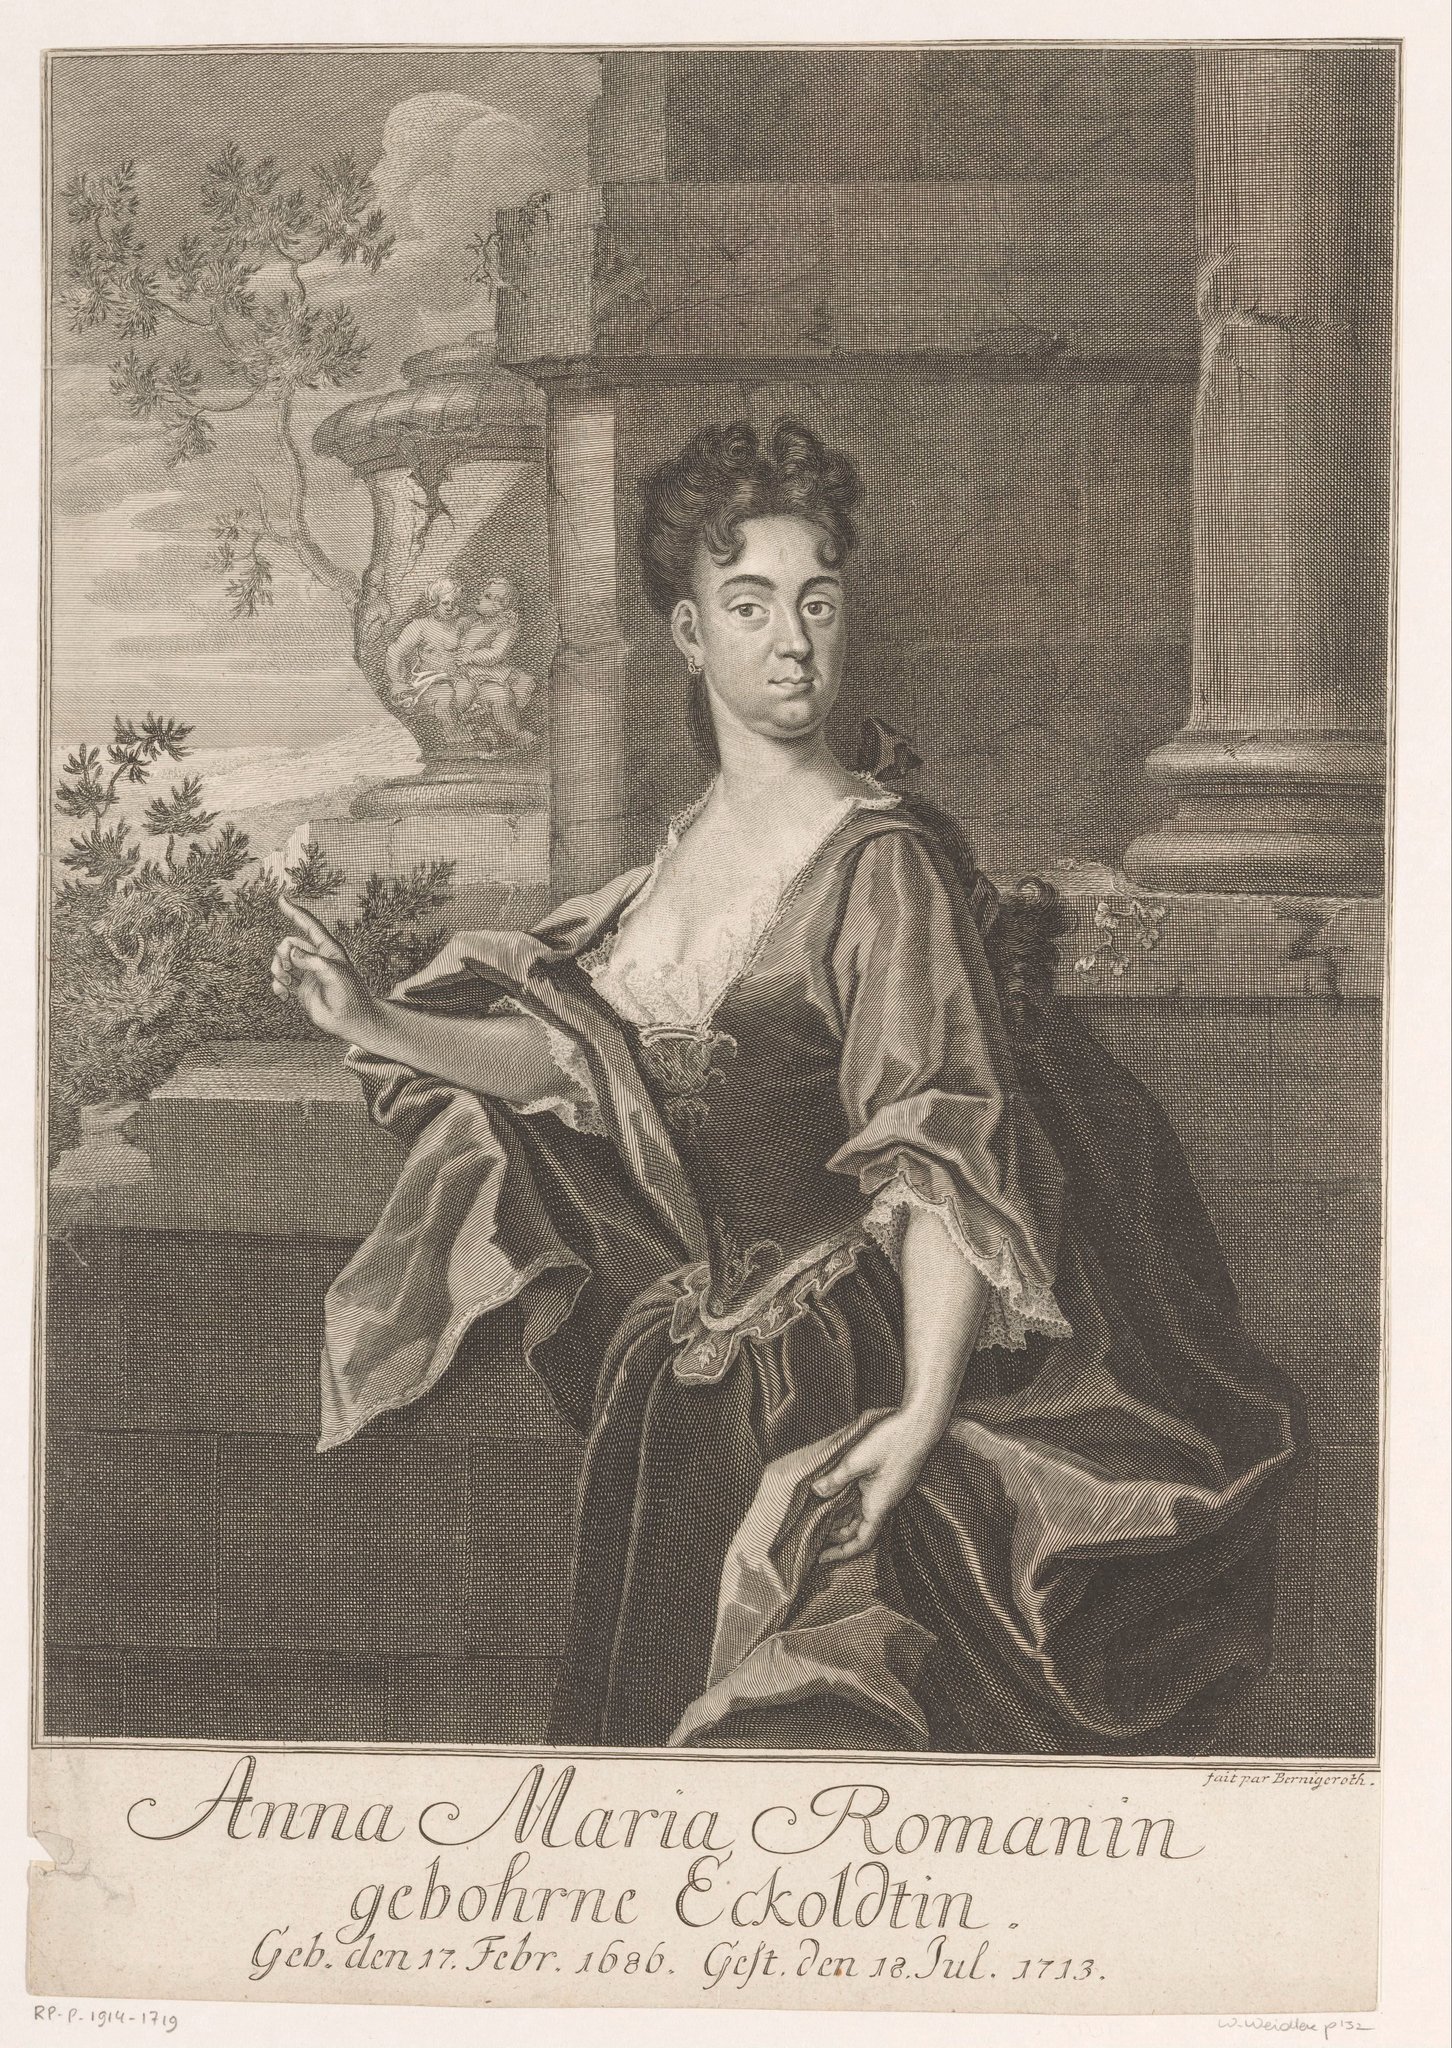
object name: print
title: Portret van Anna Maria Romanus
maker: martin bernigeroth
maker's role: print maker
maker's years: 1670-1733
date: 1713-1733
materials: paper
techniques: engraving, etching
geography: leipzig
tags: historical persons - bb - woman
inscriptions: collector's mark: Lugt 2228